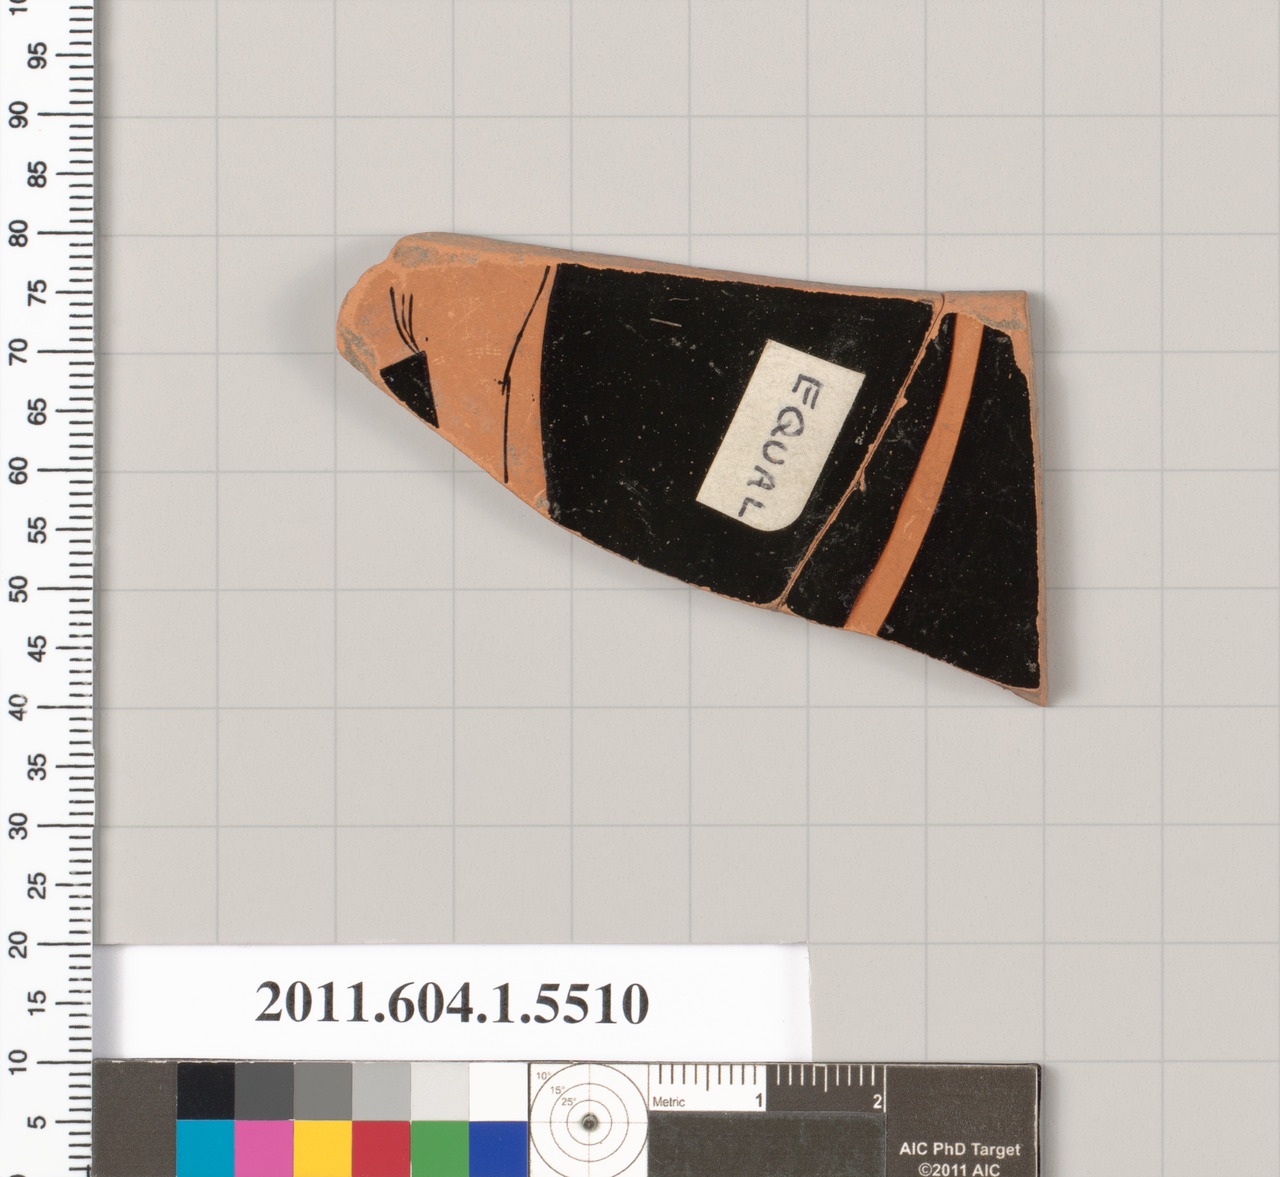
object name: kylix fragment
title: Terracotta fragment of a kylix (drinking cup)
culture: greek, attic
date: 500-480 BCE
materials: terracotta